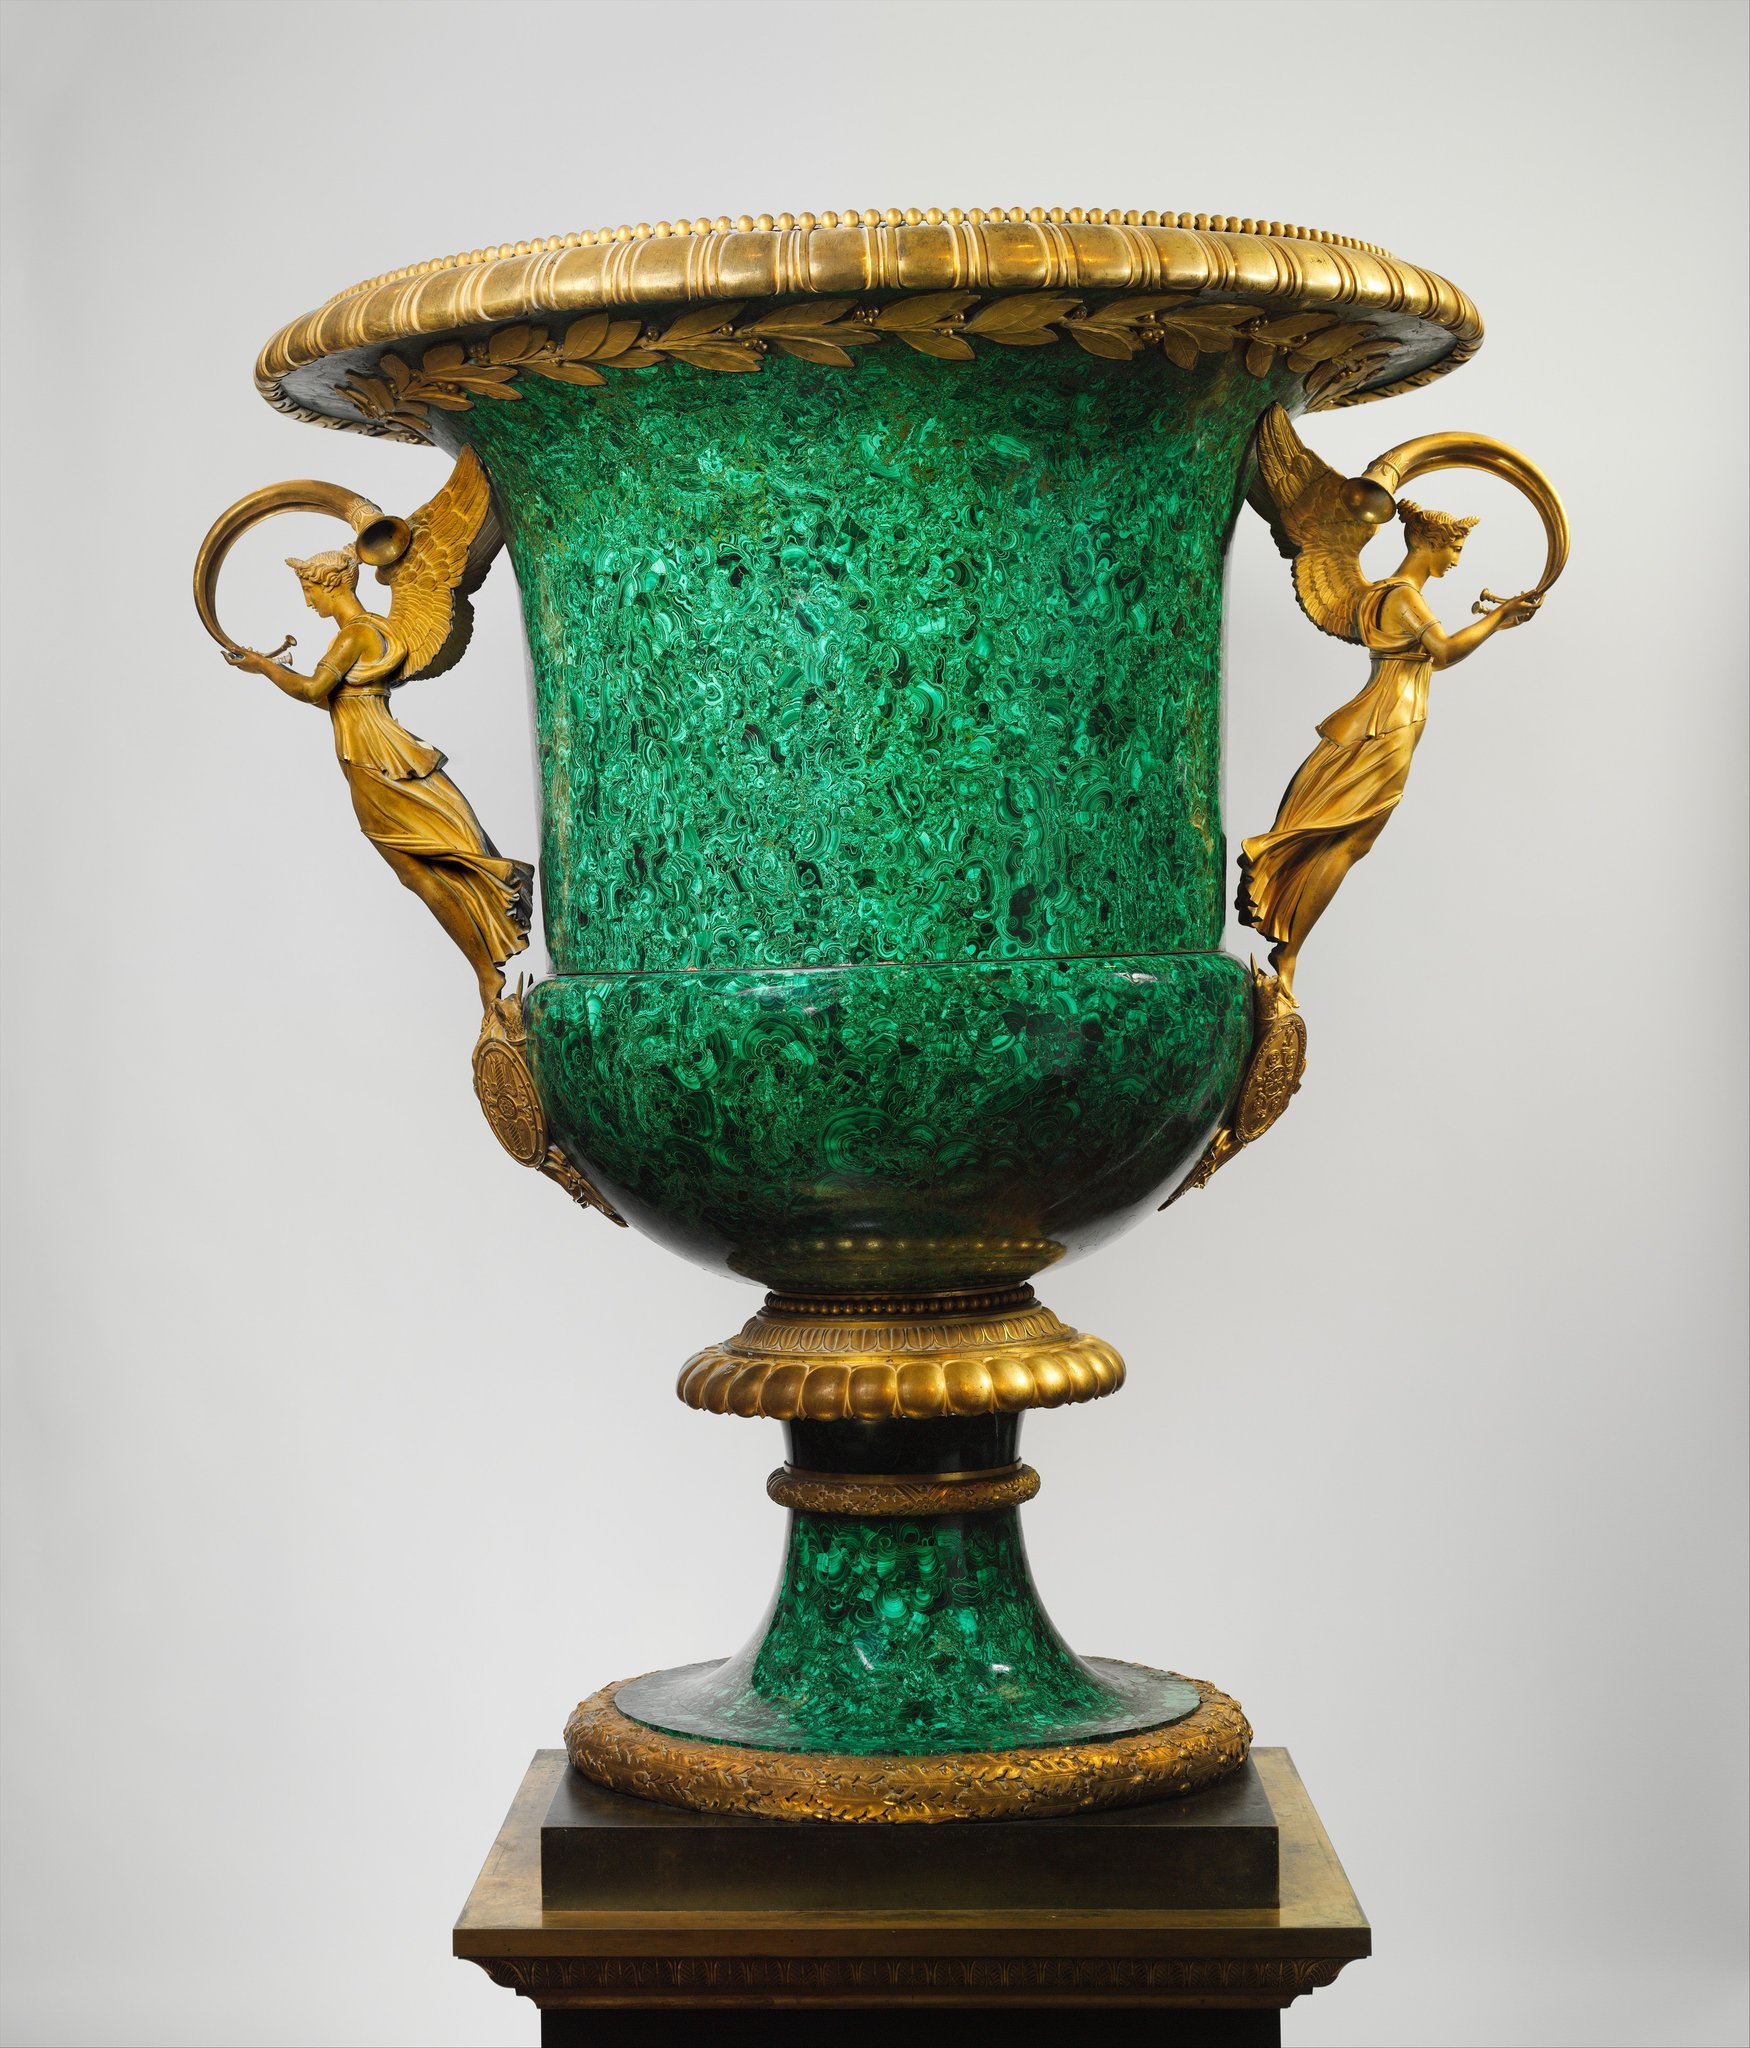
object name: vase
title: Monumental vase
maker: pierre philippe thomire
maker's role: maker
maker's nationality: french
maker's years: 1751-1843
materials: bronze, gilt bronze